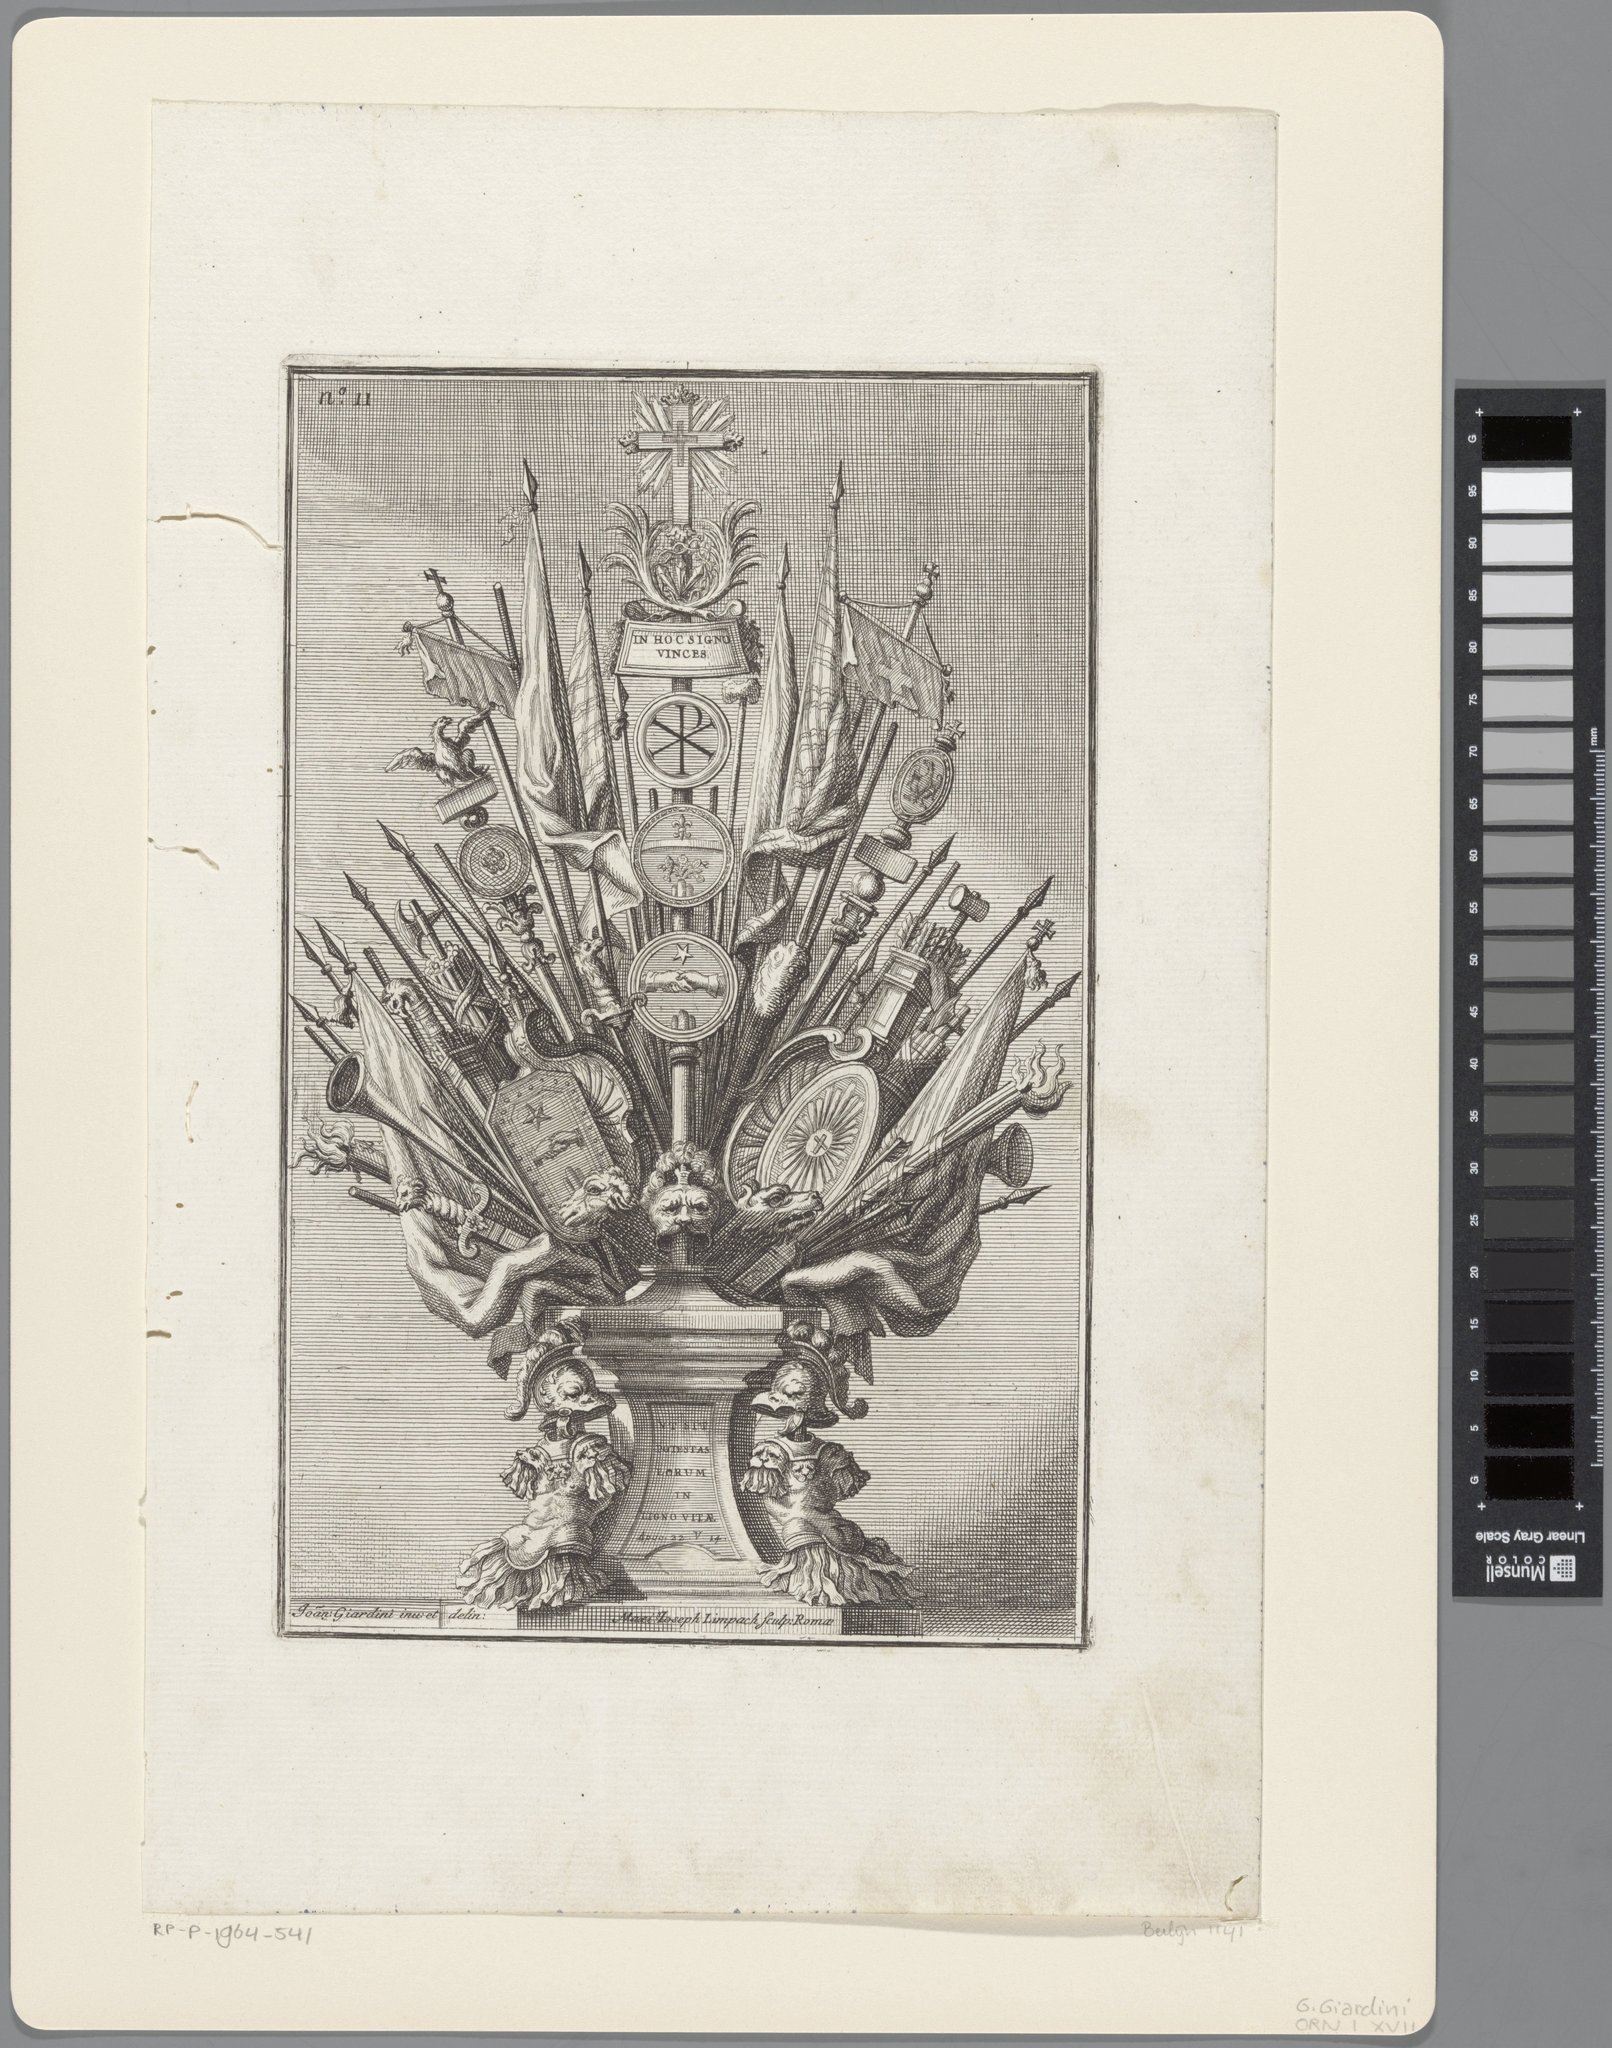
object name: ornament print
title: Reliekhouder met speren, schilden, harnassen en een kruis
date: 1714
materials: paper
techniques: etching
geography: rome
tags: protective weapons: shield, relics (and reliquaries), casting weapons: spear, weapons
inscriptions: collector's mark: Lugt 2228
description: Prent maakt deel uit van een reeks van 100 ornamentprenten naar ontwerp van Giovanni Giardini.